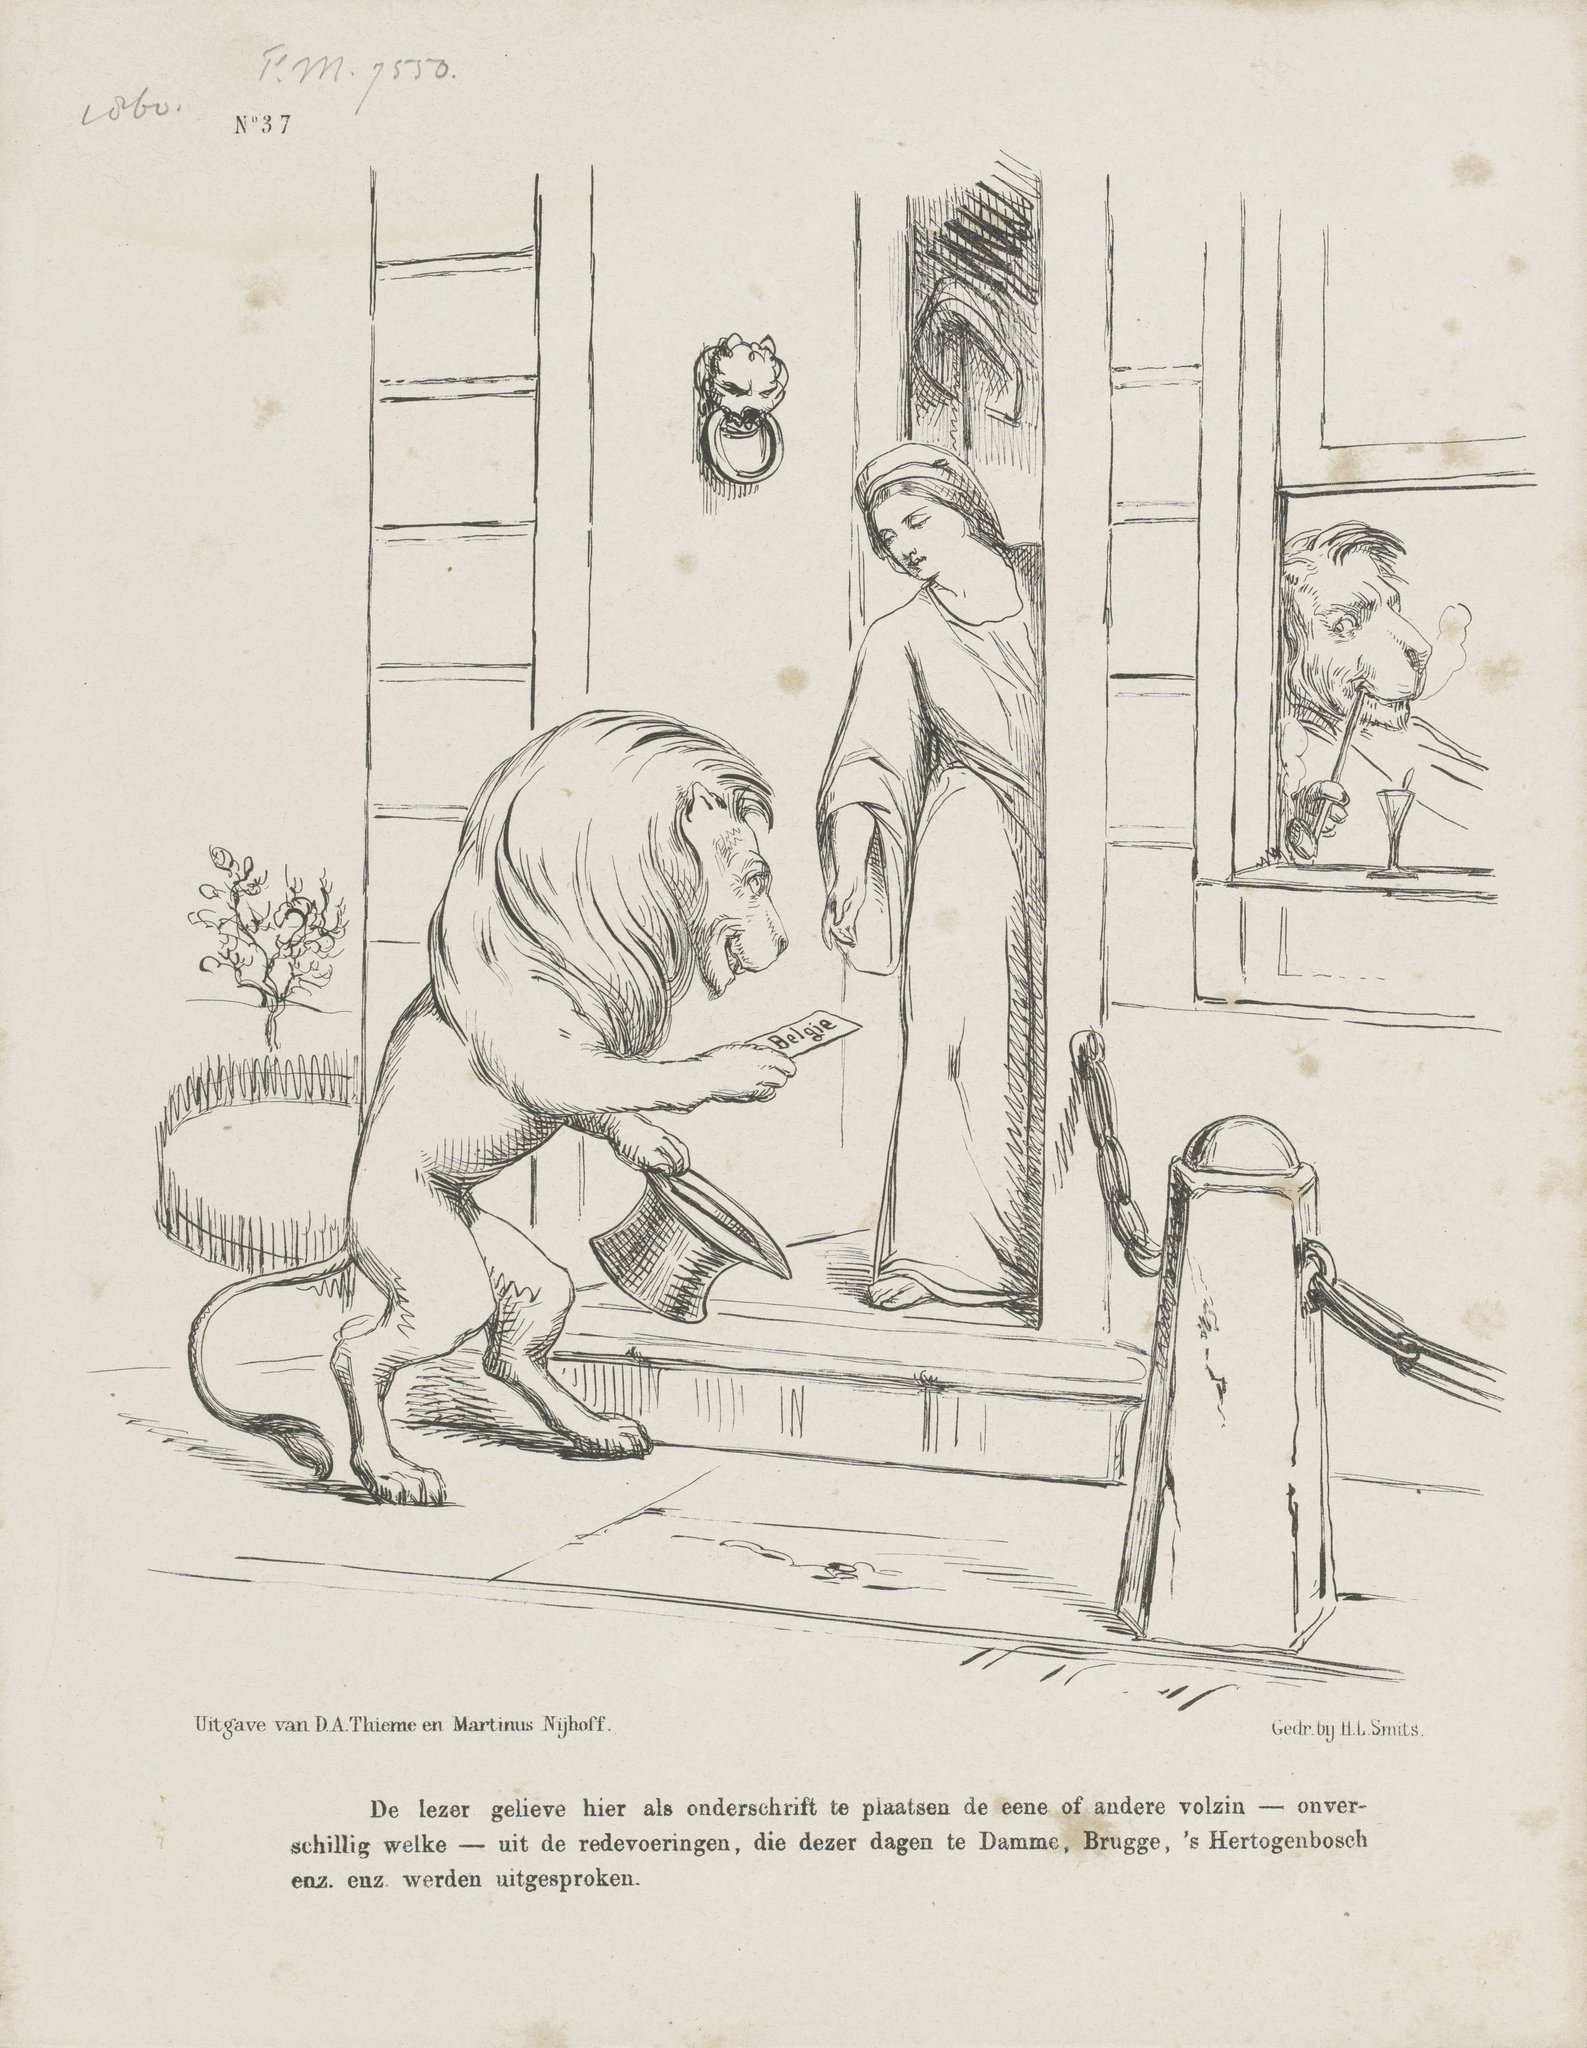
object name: print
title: Spotprent op de feesten bij de oprichting van het standbeeld van Jacob van Maerlant, 1860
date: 1860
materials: paper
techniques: lithograph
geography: netherlands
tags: visiting-card, calling-card, beasts of prey, predatory animals: lion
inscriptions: collector's mark: Lugt 2228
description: Spotprent op de feesten bij de oprichting van het standbeeld van Jacob van Maerlant op de markt in Damme en het letterkundig congres in Den Bosch. De Belgische leeuw geeft zijn visitekaartje af bij de Nederlandse leeuw. Plaat verschenen bij het weekblad De Nederlandsche Spectator, nr. 37, 15 september 1860.